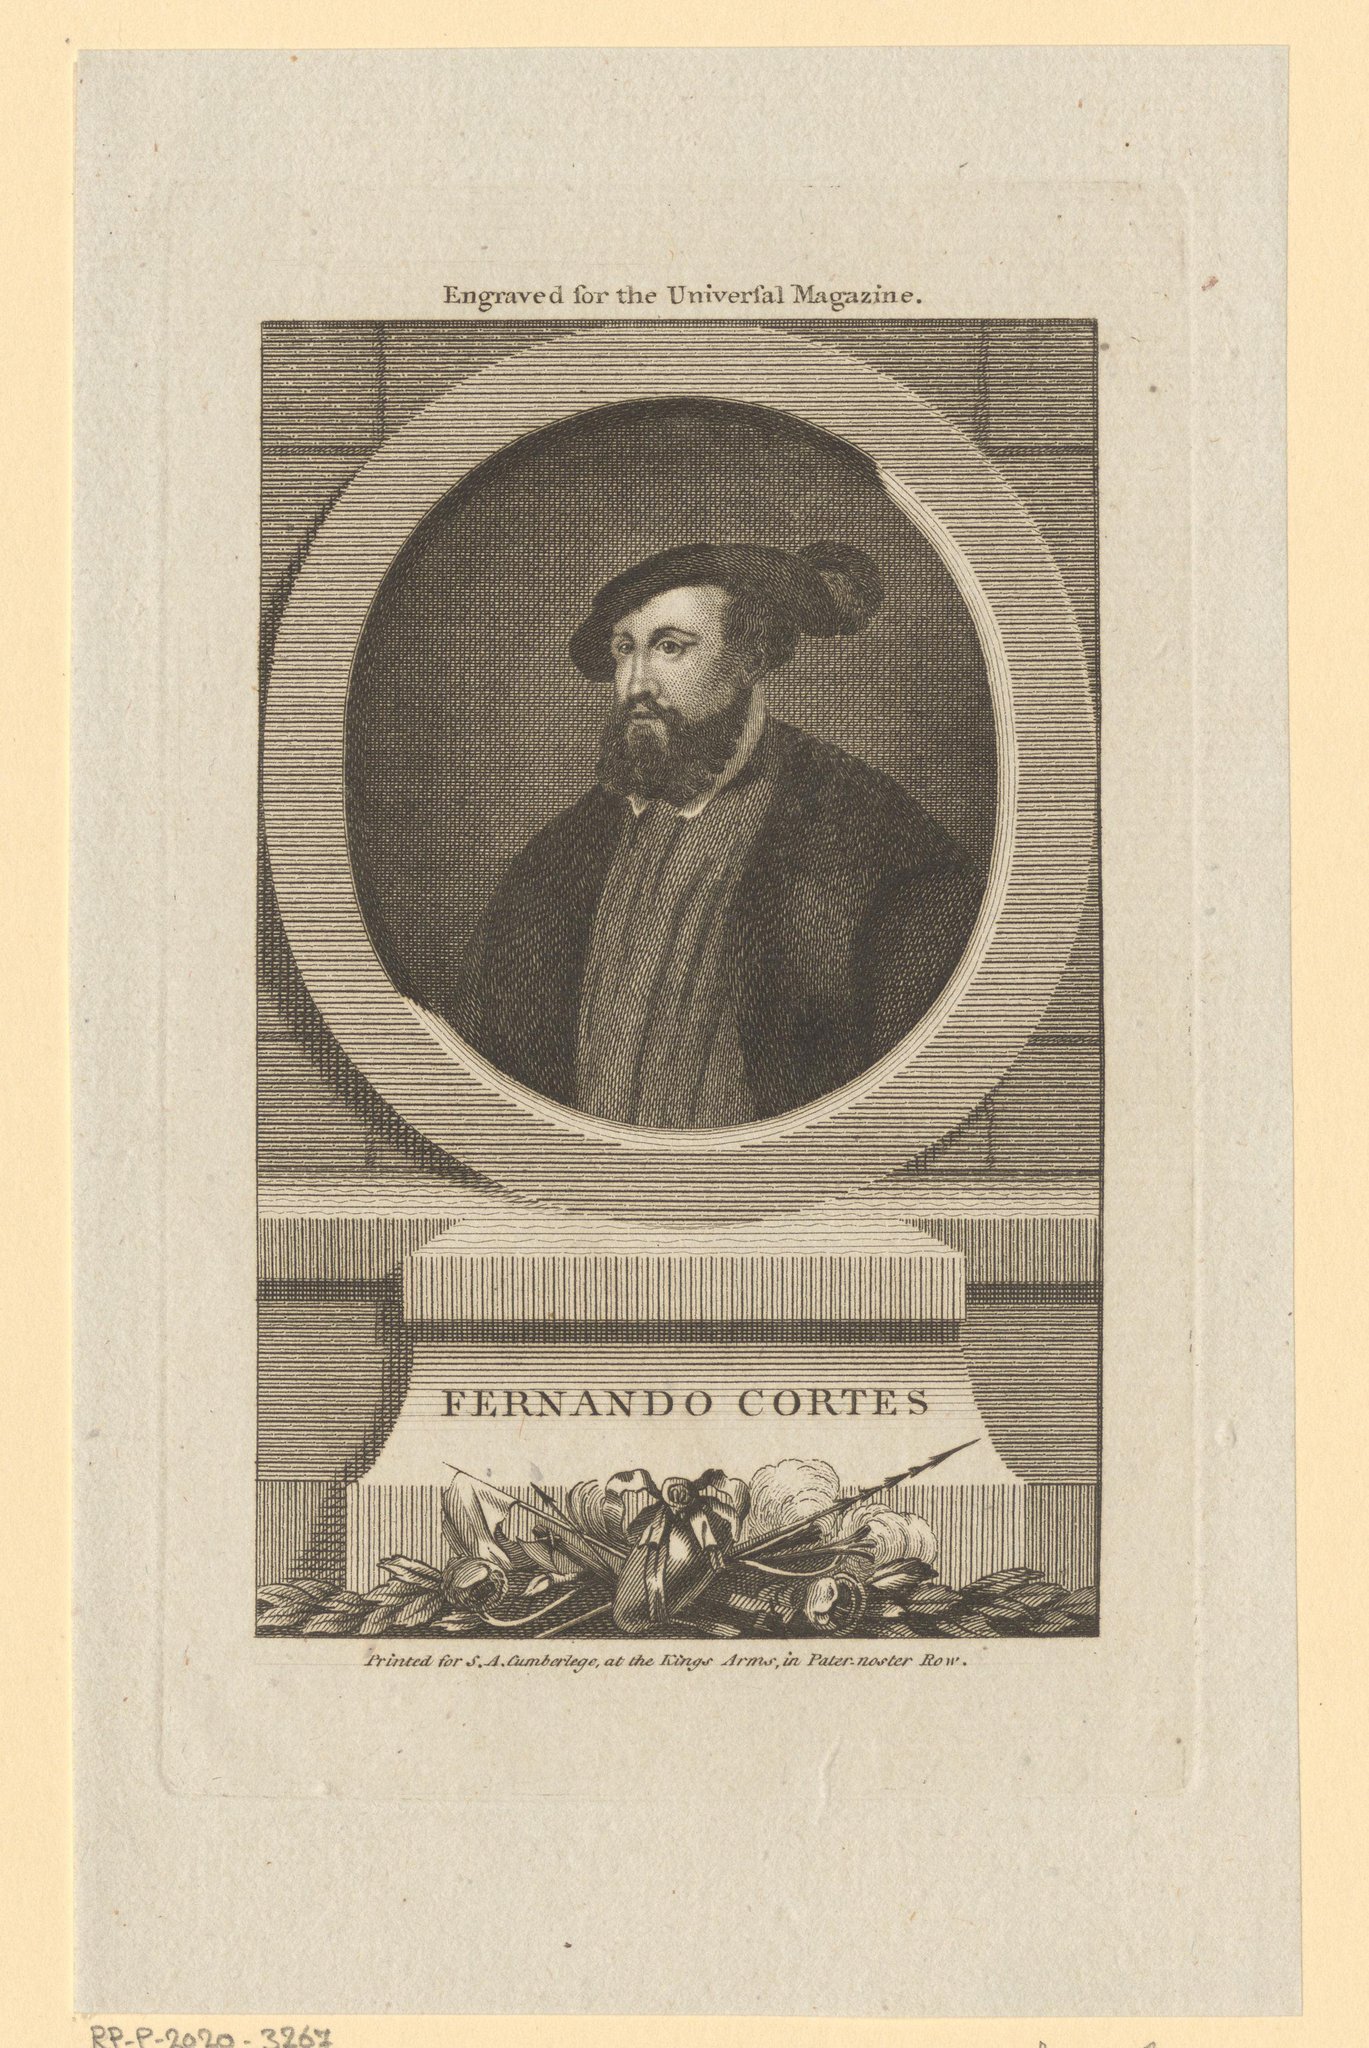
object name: print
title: Portret van Hernán Cortés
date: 1783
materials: paper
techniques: engraving, etching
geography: london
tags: historical persons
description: Prent uit: The Universal Magazine of Knowledge and Pleasure, 1747-1814.